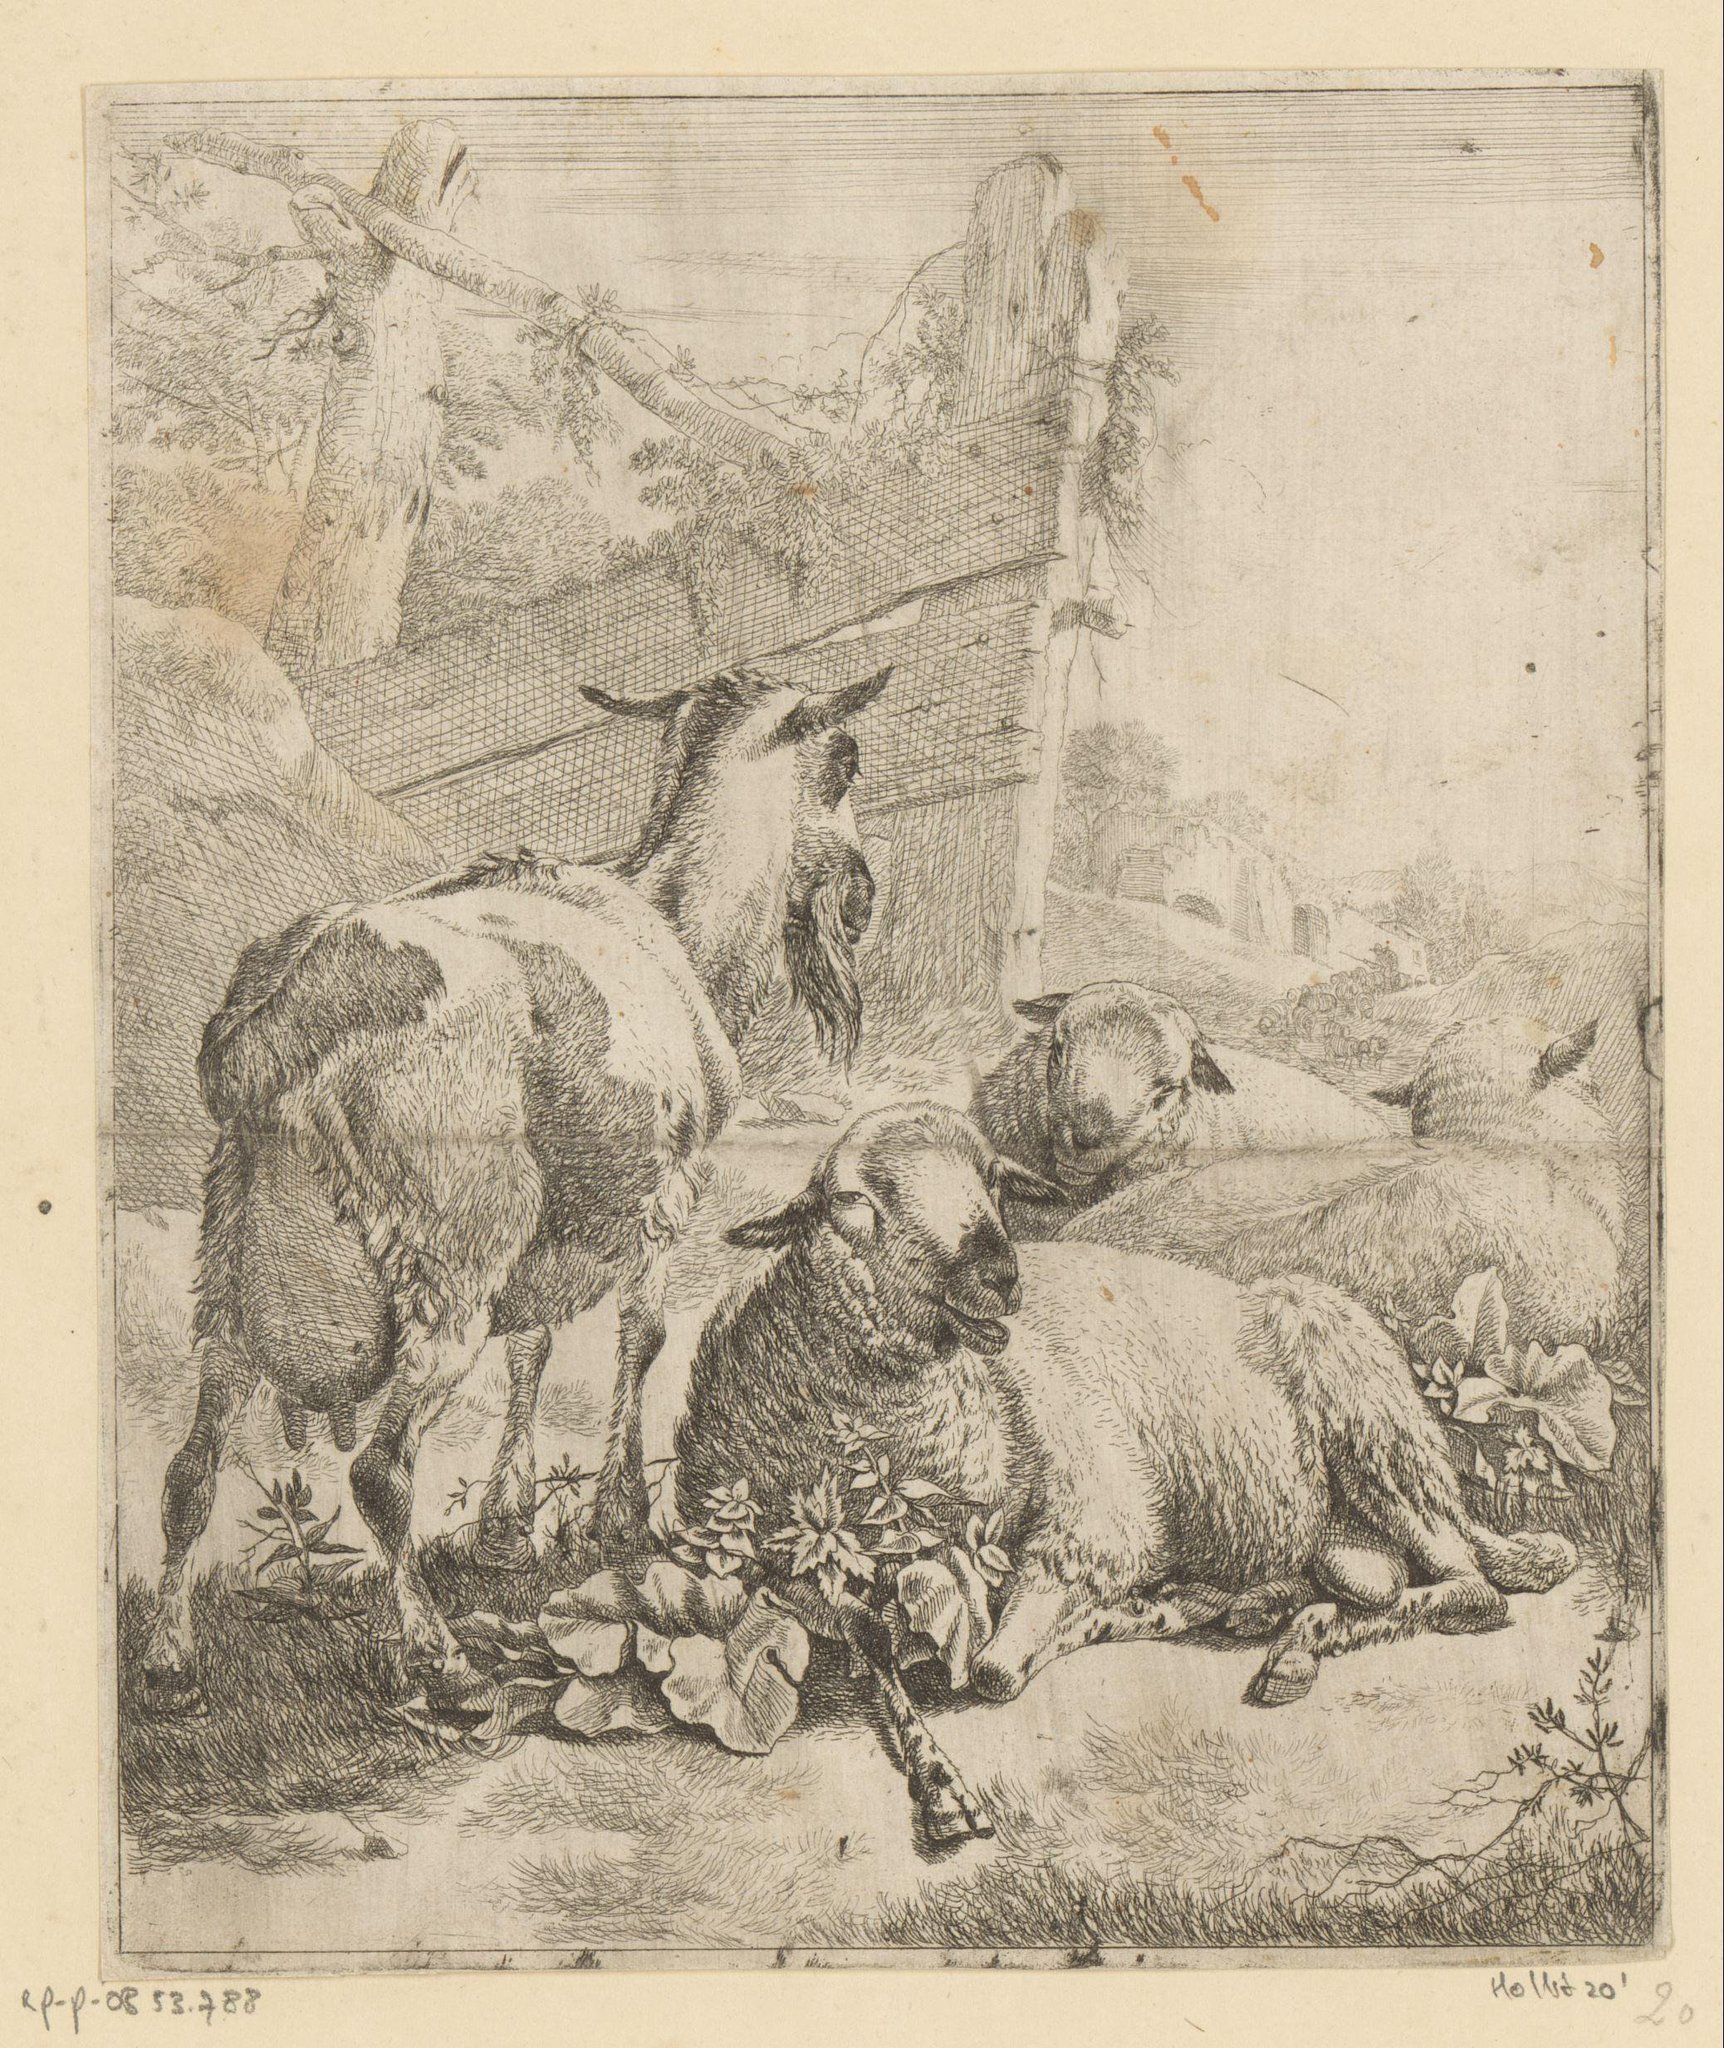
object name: print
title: Schapen, geiten en koeien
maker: johann heinrich roos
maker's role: draughtsman, print maker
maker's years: 1631-1685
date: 1668-1670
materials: paper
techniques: etching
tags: landscapes, ram, goat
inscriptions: collector's mark: Lugt 240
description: Serie van twaalf prenten, waarvan één titelprent.